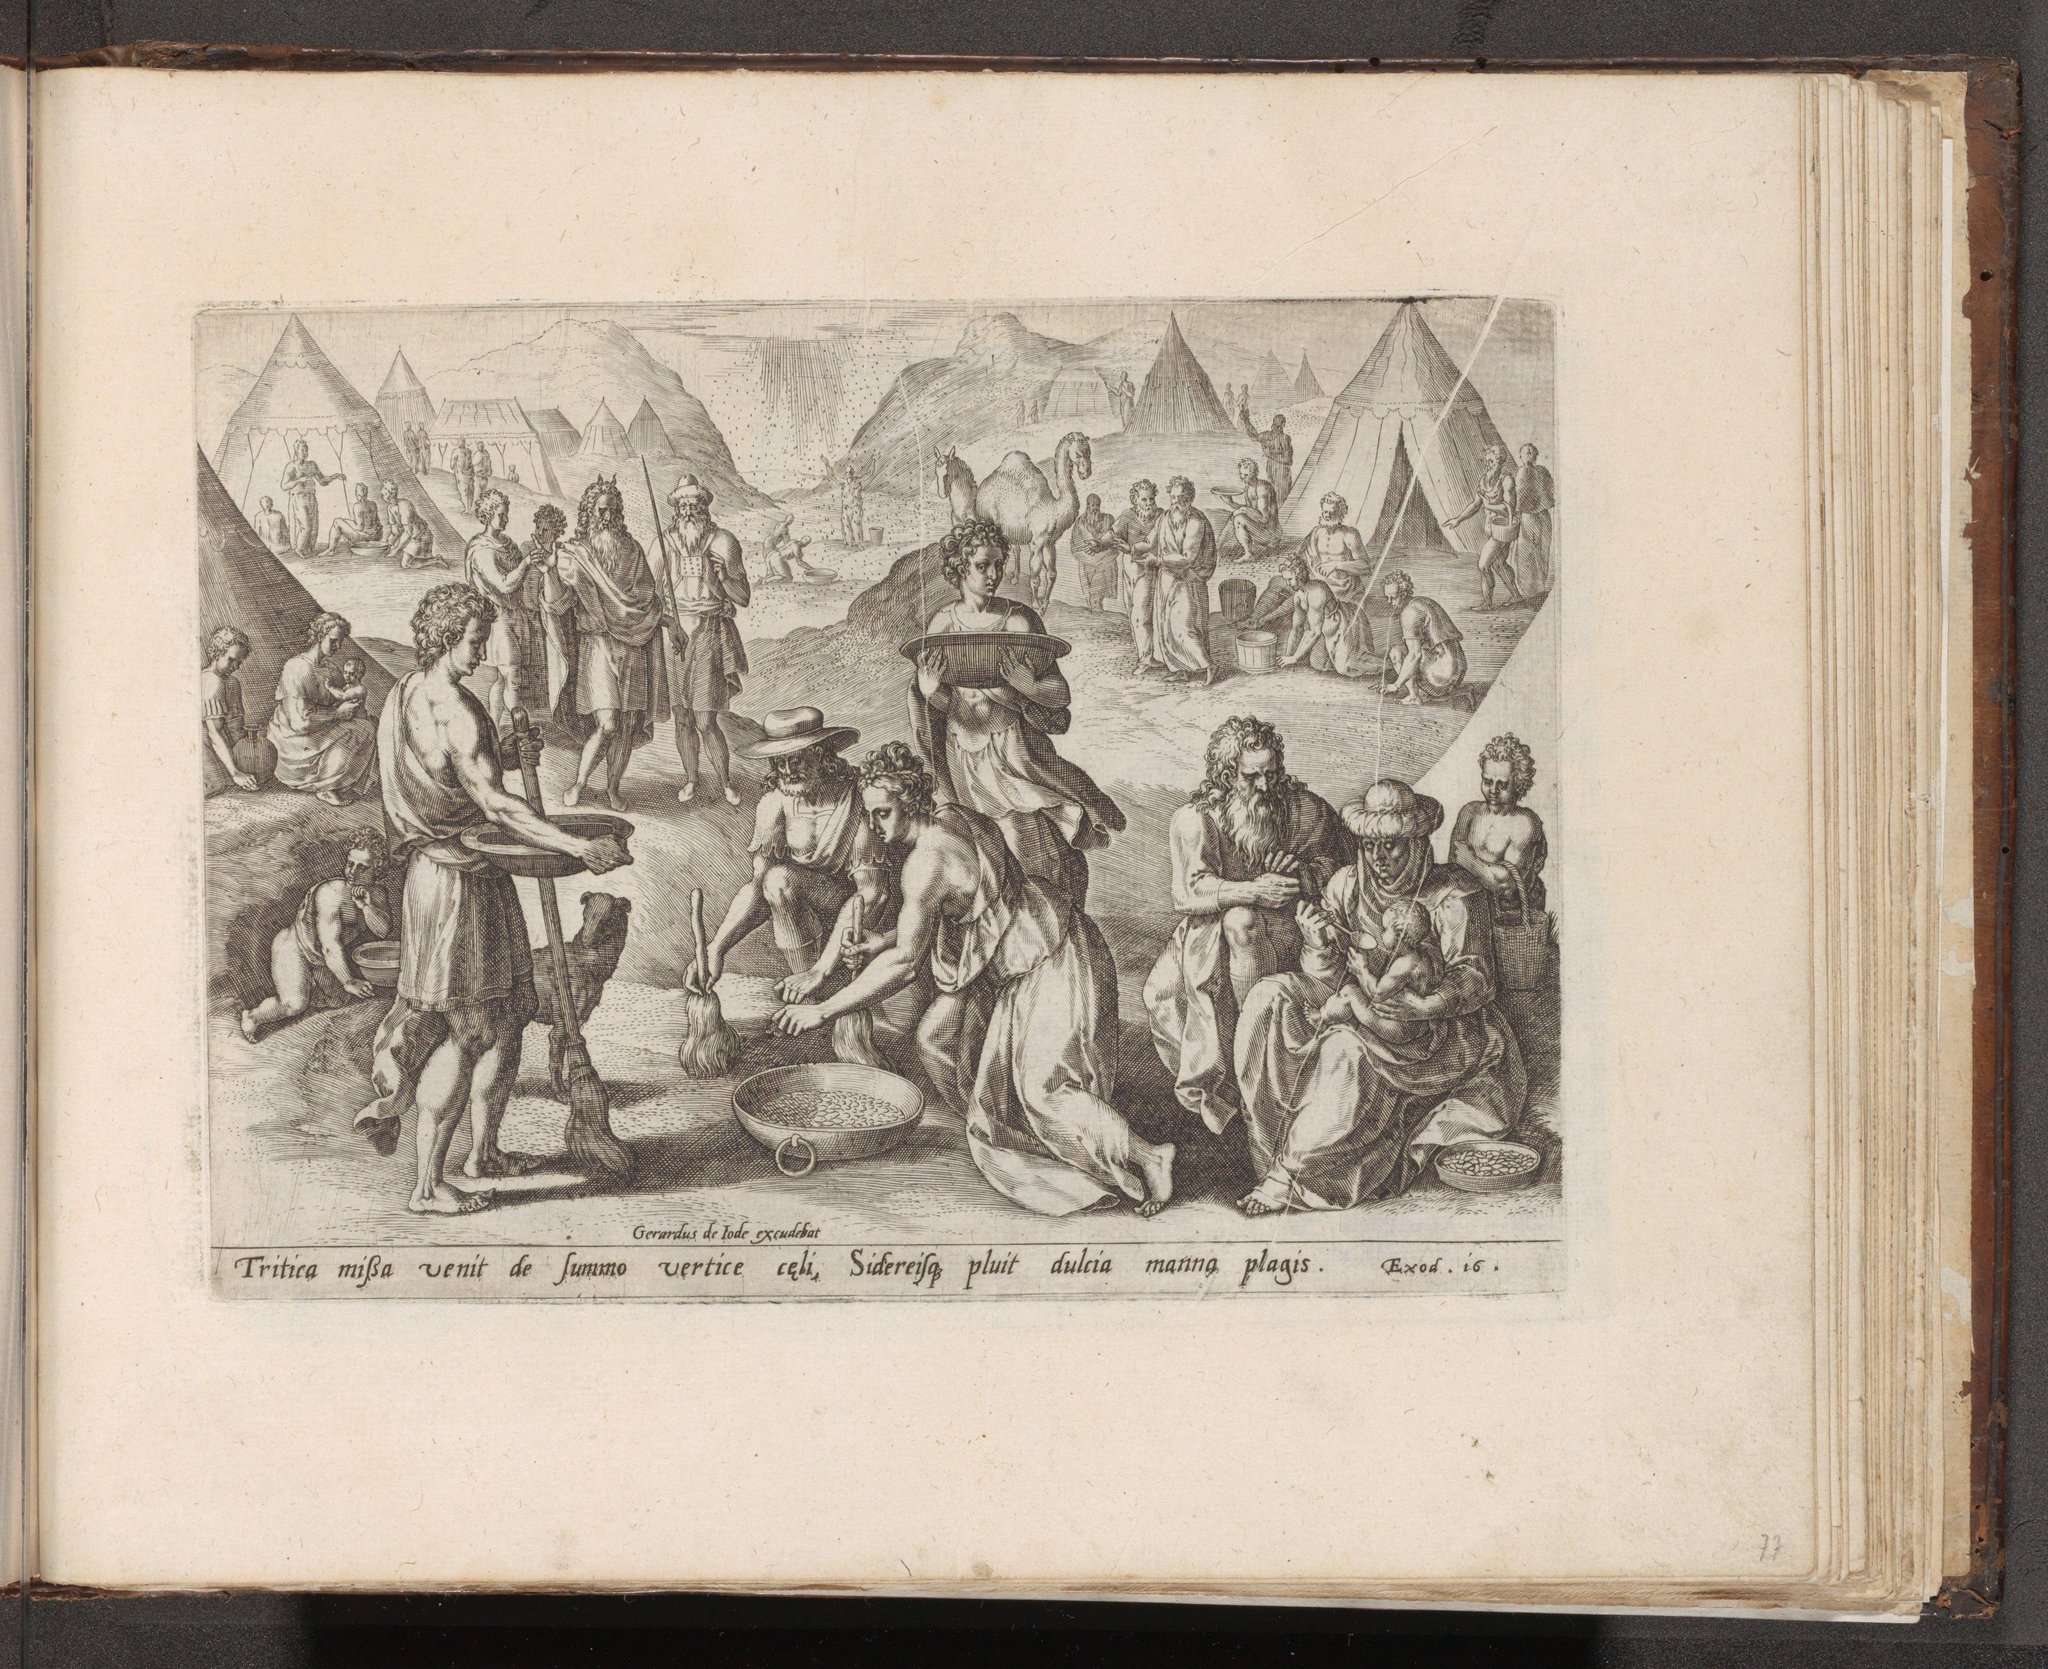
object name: print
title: Verzamelen van het manna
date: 1579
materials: paper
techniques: engraving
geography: antwerp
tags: the gathering of manna (in baskets and pots), in the morning manna falls to the earth ~ exodus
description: De Israëlieten verzamelen het manna in potten en manden in de woestijn. Midden achter Mozes, met zijn staf, en Aäron. Op de achtergrond regent het manna uit de hemel. Onder de voorstelling een verwijzing in het Latijn naar de Bijbeltekst in Ex. 16. Prent maakt deel uit van een album.